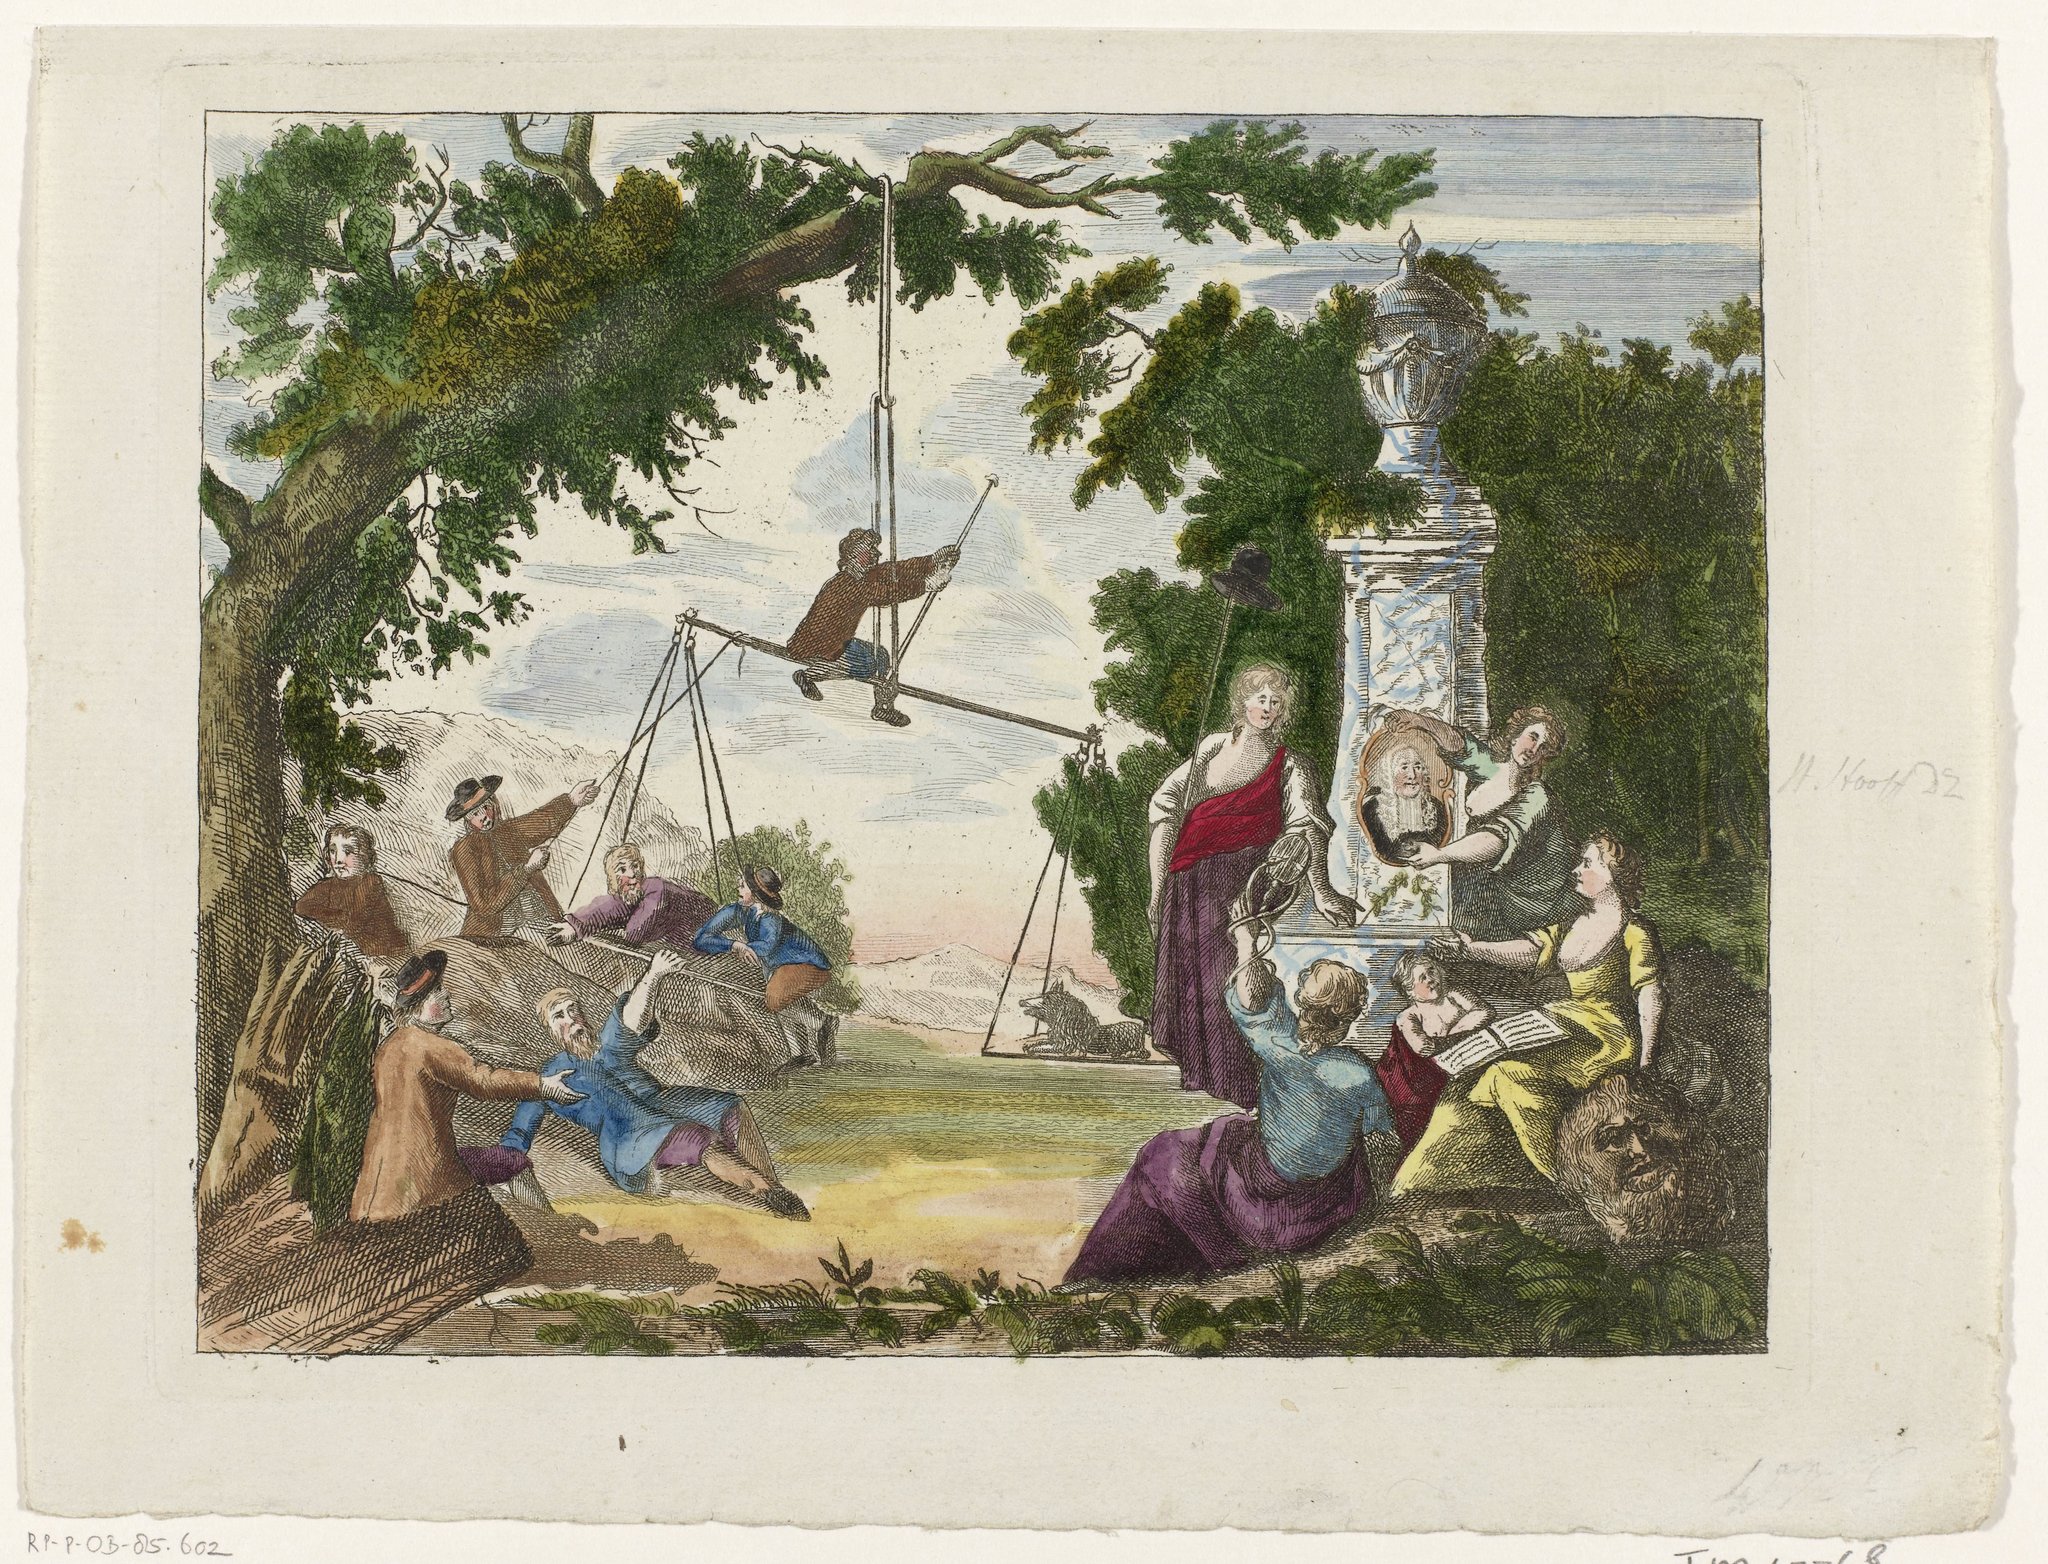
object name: print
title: Keeshond en Oranjeklanten op de weegschaal, 1787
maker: Anonymous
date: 1787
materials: paper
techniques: engraving, etching, hand coloring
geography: northern netherlands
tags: hendrik danielsz. hooft, prudence, 'prudentia'; 'prudenza' (ripa) ~ one of the four cardinal virtues, scales, allegorical representations ~ religion; 'religione', 'religione de ss. mauritio e lazaro', 'religione vera christiana' (ripa), freedom, liberty; 'libertà' (ripa) (+ abstract concept represented by female figure), patriots (1780-1795)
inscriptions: collector's mark: Lugt 2228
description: Allegorie waarin een kleine keeshond (patriotten) en Oranjeklanten op een weegschaal aan een boom worden gewogen. De keeshond doet de weegschaal doorslaan ondanks alle verwoede pogingen van de Oranjeklanten om het gewicht aan hun zijde te krijgen. Aan de zijde van de keeshond bevinden zich de Vrijheid, Voorzichtigheid, Liefde en Godsdienst bij een monument met een portret van de Amsterdamse burgemeester Hendrik Danielsz. Hooft, 1787.